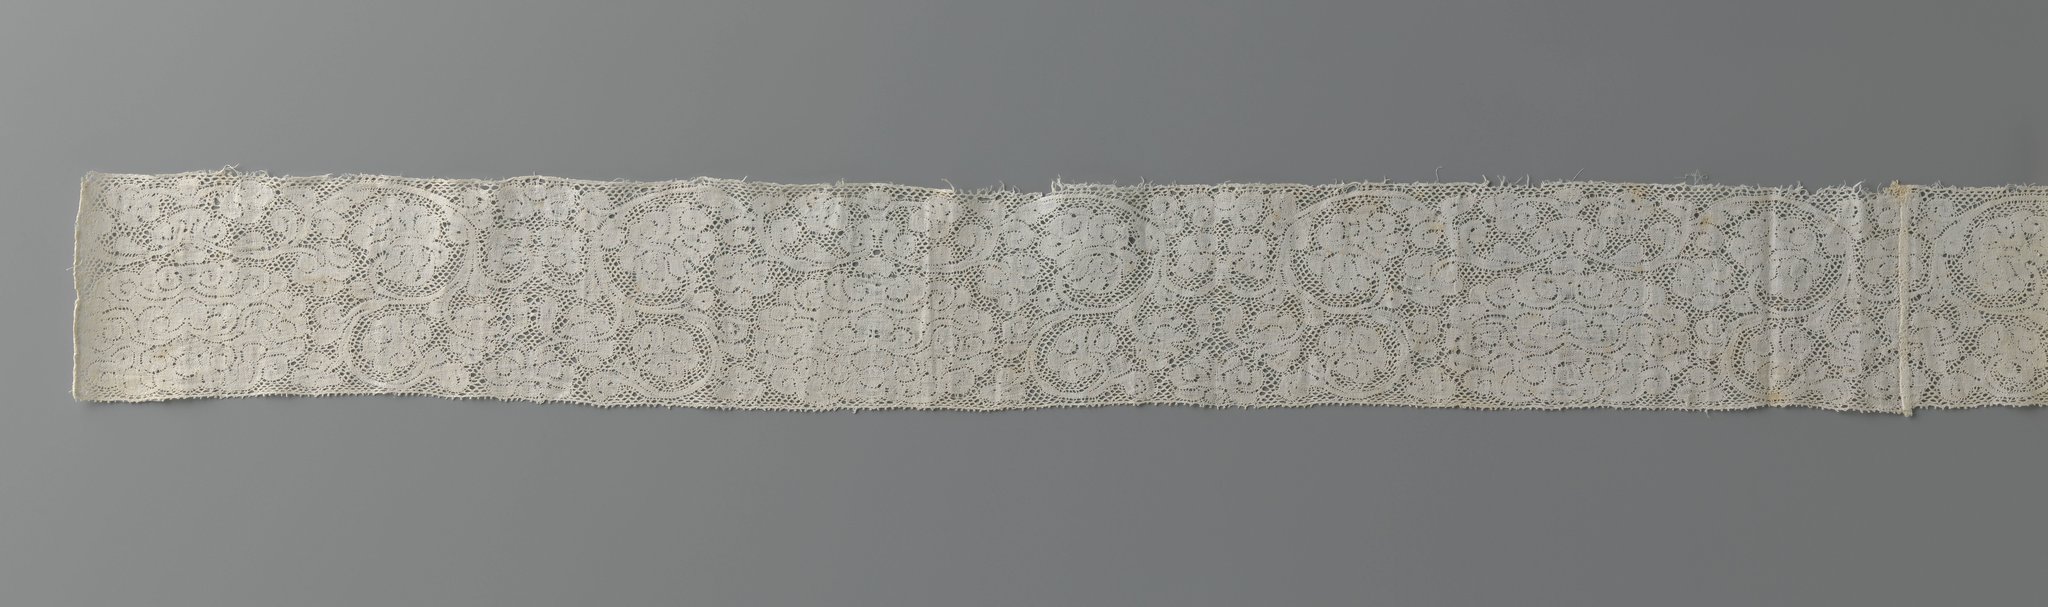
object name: strip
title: Strook kloskant met grote en kleine pioenrozen aan s-voluutranken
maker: Anonymous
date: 1650-1660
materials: linen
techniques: lace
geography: southern netherlands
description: Strook naturelkleurige Hollandse kloskant. Het zich herhalende en symmetrische patroon bestaat uit een grote pioenroos tussen s-voluutranken met kleinere pioenrozen aan omkrullende zijstengels. De motieven zijn gemaakt in linnenslag met opengewerkte randjes die ook voor de tekening in de bloemen zorgen. De motieven zijn met elkaar verbonden door een traliegrond met vlechtslagen. Boven- en onderzijde van de strook zijn recht afgewerkt waarbij de onderzijde is voorzien van picots.